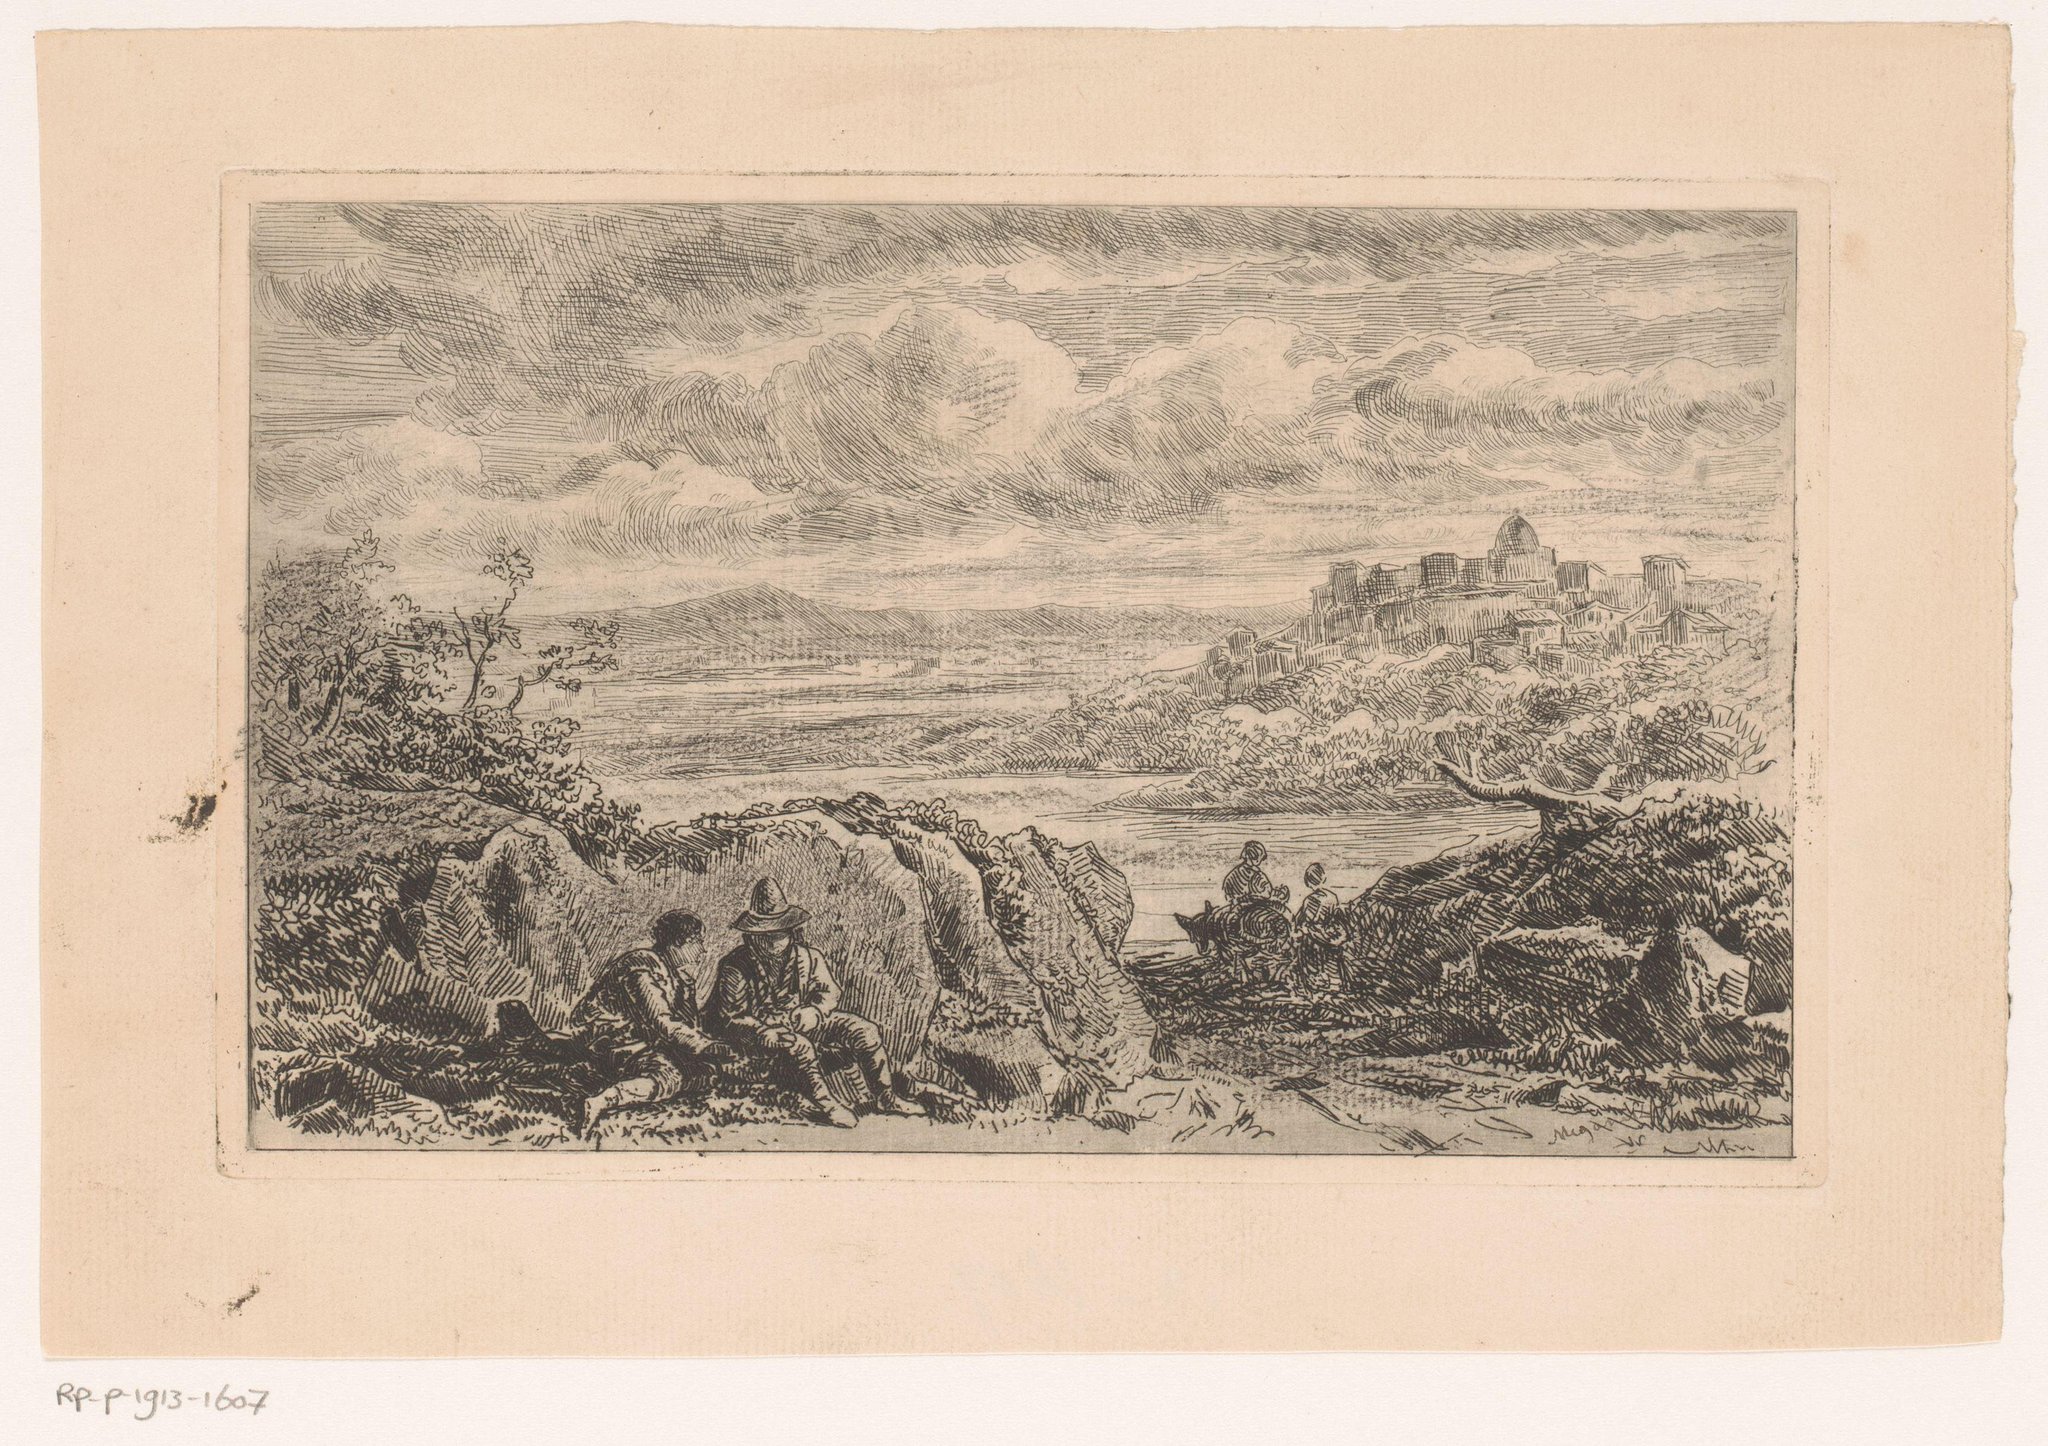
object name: print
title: Gezicht op het meer van Albano en Castel Gandolfo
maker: joseph meganck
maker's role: print maker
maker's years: 1807-1891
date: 1817-1888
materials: chalk, paper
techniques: etching, intaglio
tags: riding a horse, ass, or mule; rider, horseman, lake, city-view, and landscape with man-made constructions (+ city(-scape) with figures, staffage)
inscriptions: collector's mark: Lugt 2228